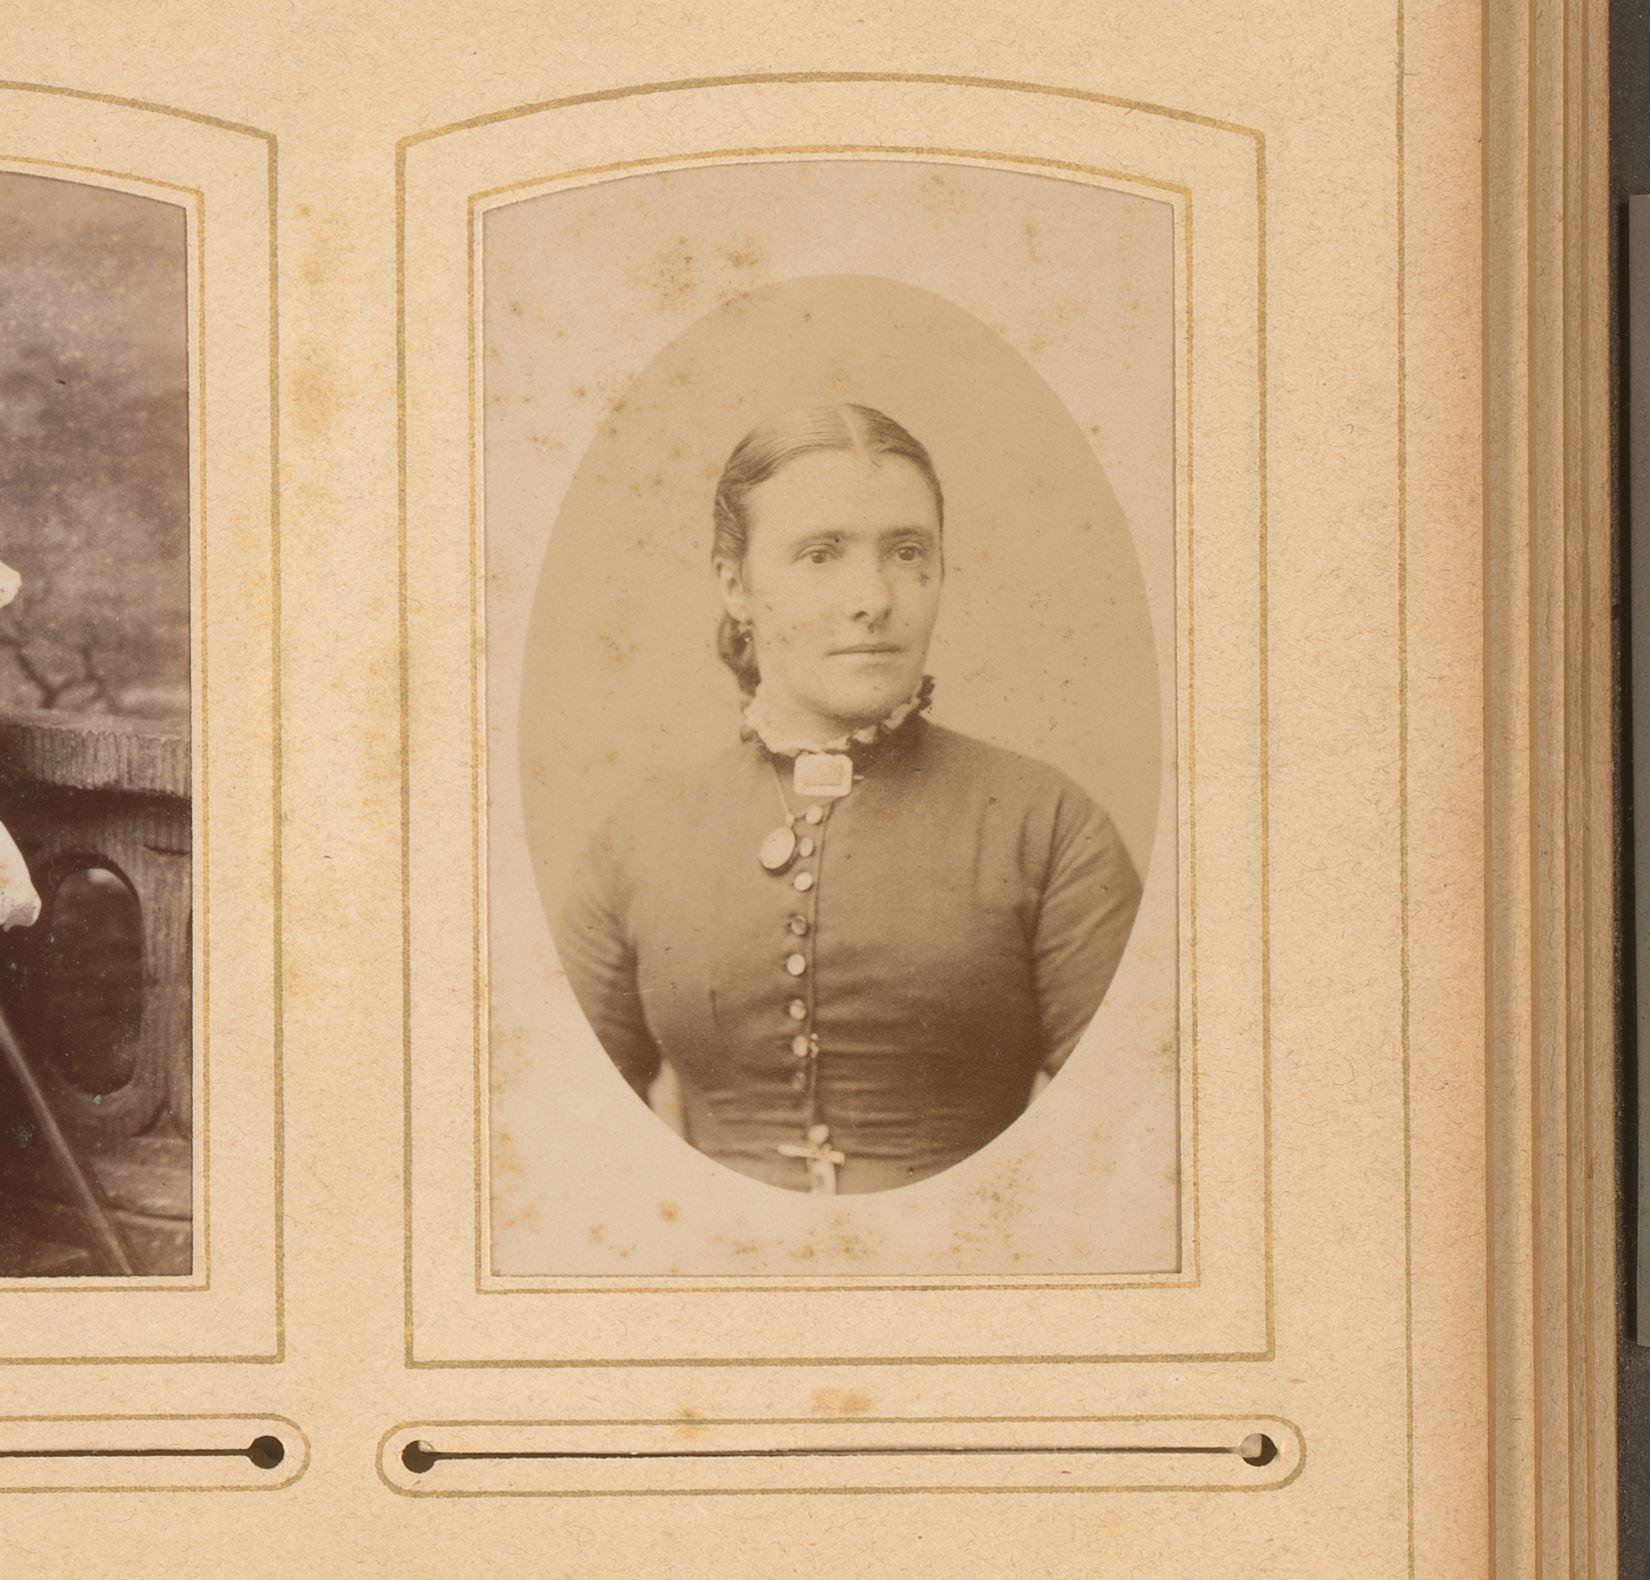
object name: carte de visite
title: Portret van een vrouw met halsketting met medaillon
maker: johannes leonardus van der heijden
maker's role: fotograaf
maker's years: 1856-1937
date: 1878-1900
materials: cardboard, photographic support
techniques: albumen print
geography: amsterdam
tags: historical persons - bb - woman, pendant, trinket, 'breloque'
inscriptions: inscription: ‘Photographie Artistique./ Johs. L. van der Heijden/ Amsterdam/ Heiligenweg hoek Singel 435./ Specialiteit in overanderlijke/ Vergrootingen.’